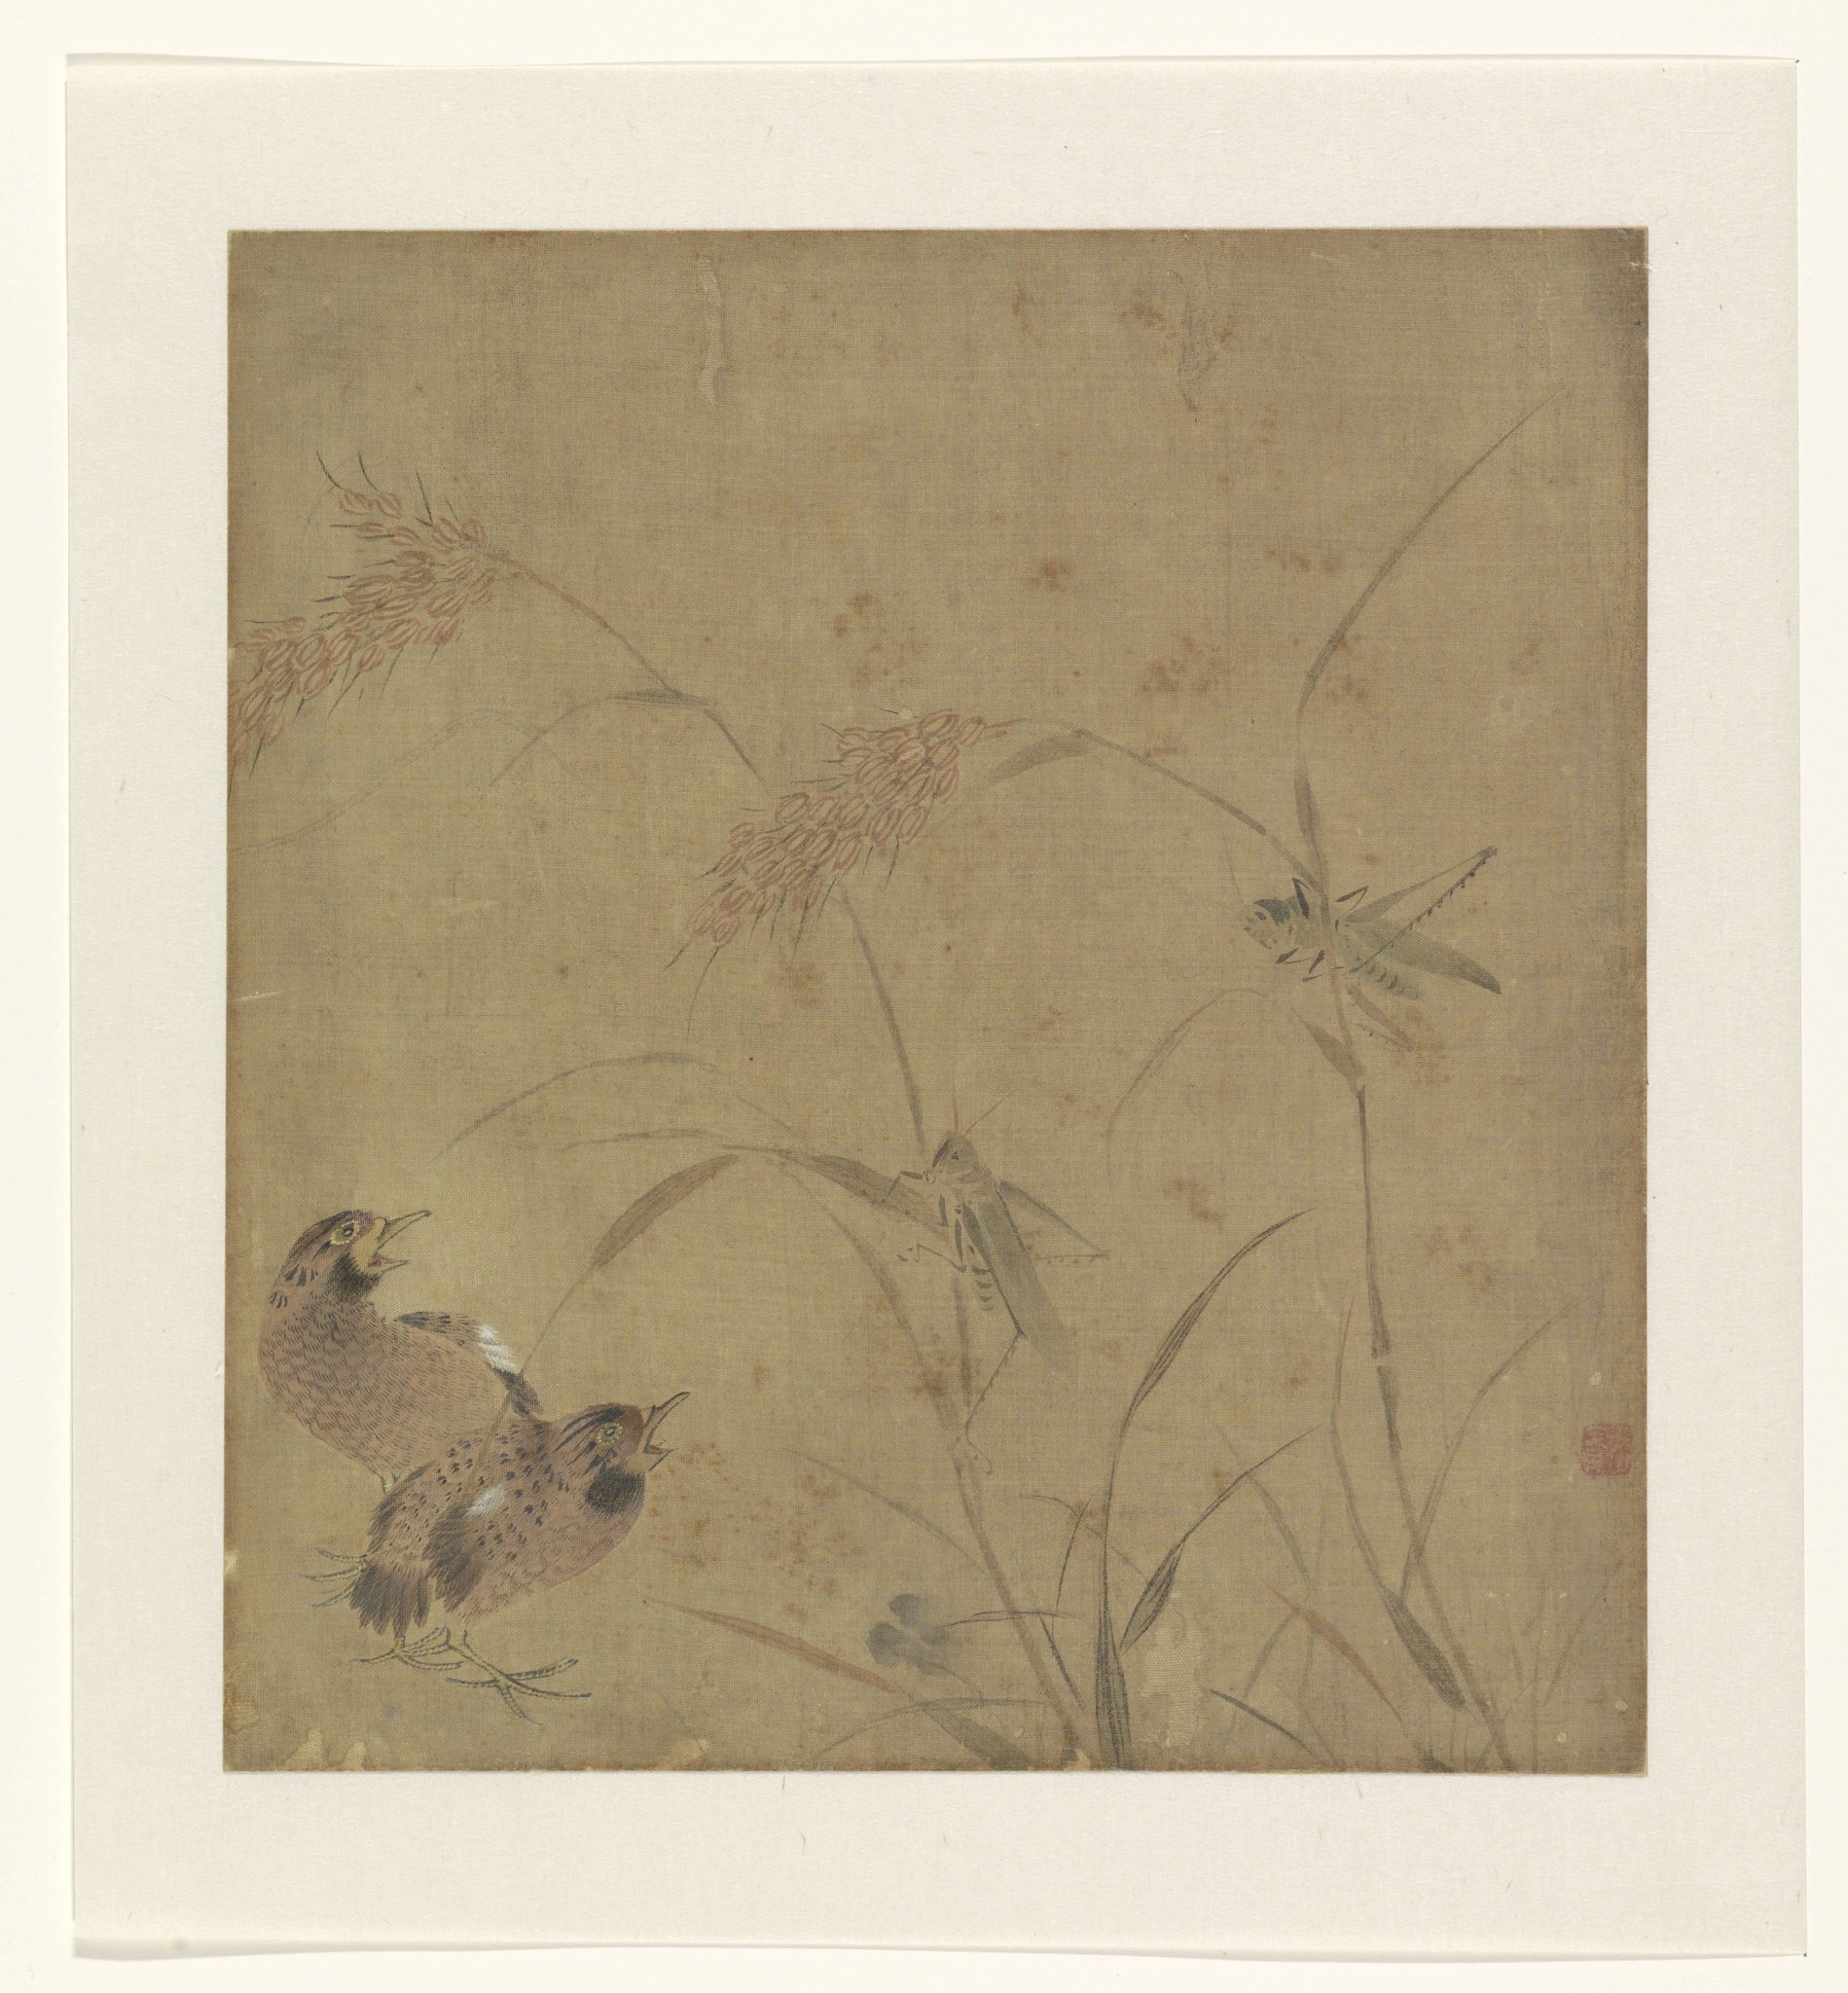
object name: album leaf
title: Albumblad met een voorstelling van kwartels bij gierststengels met sprinkhanen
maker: Anonymous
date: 1600-1699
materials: silk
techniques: colors on silk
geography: china